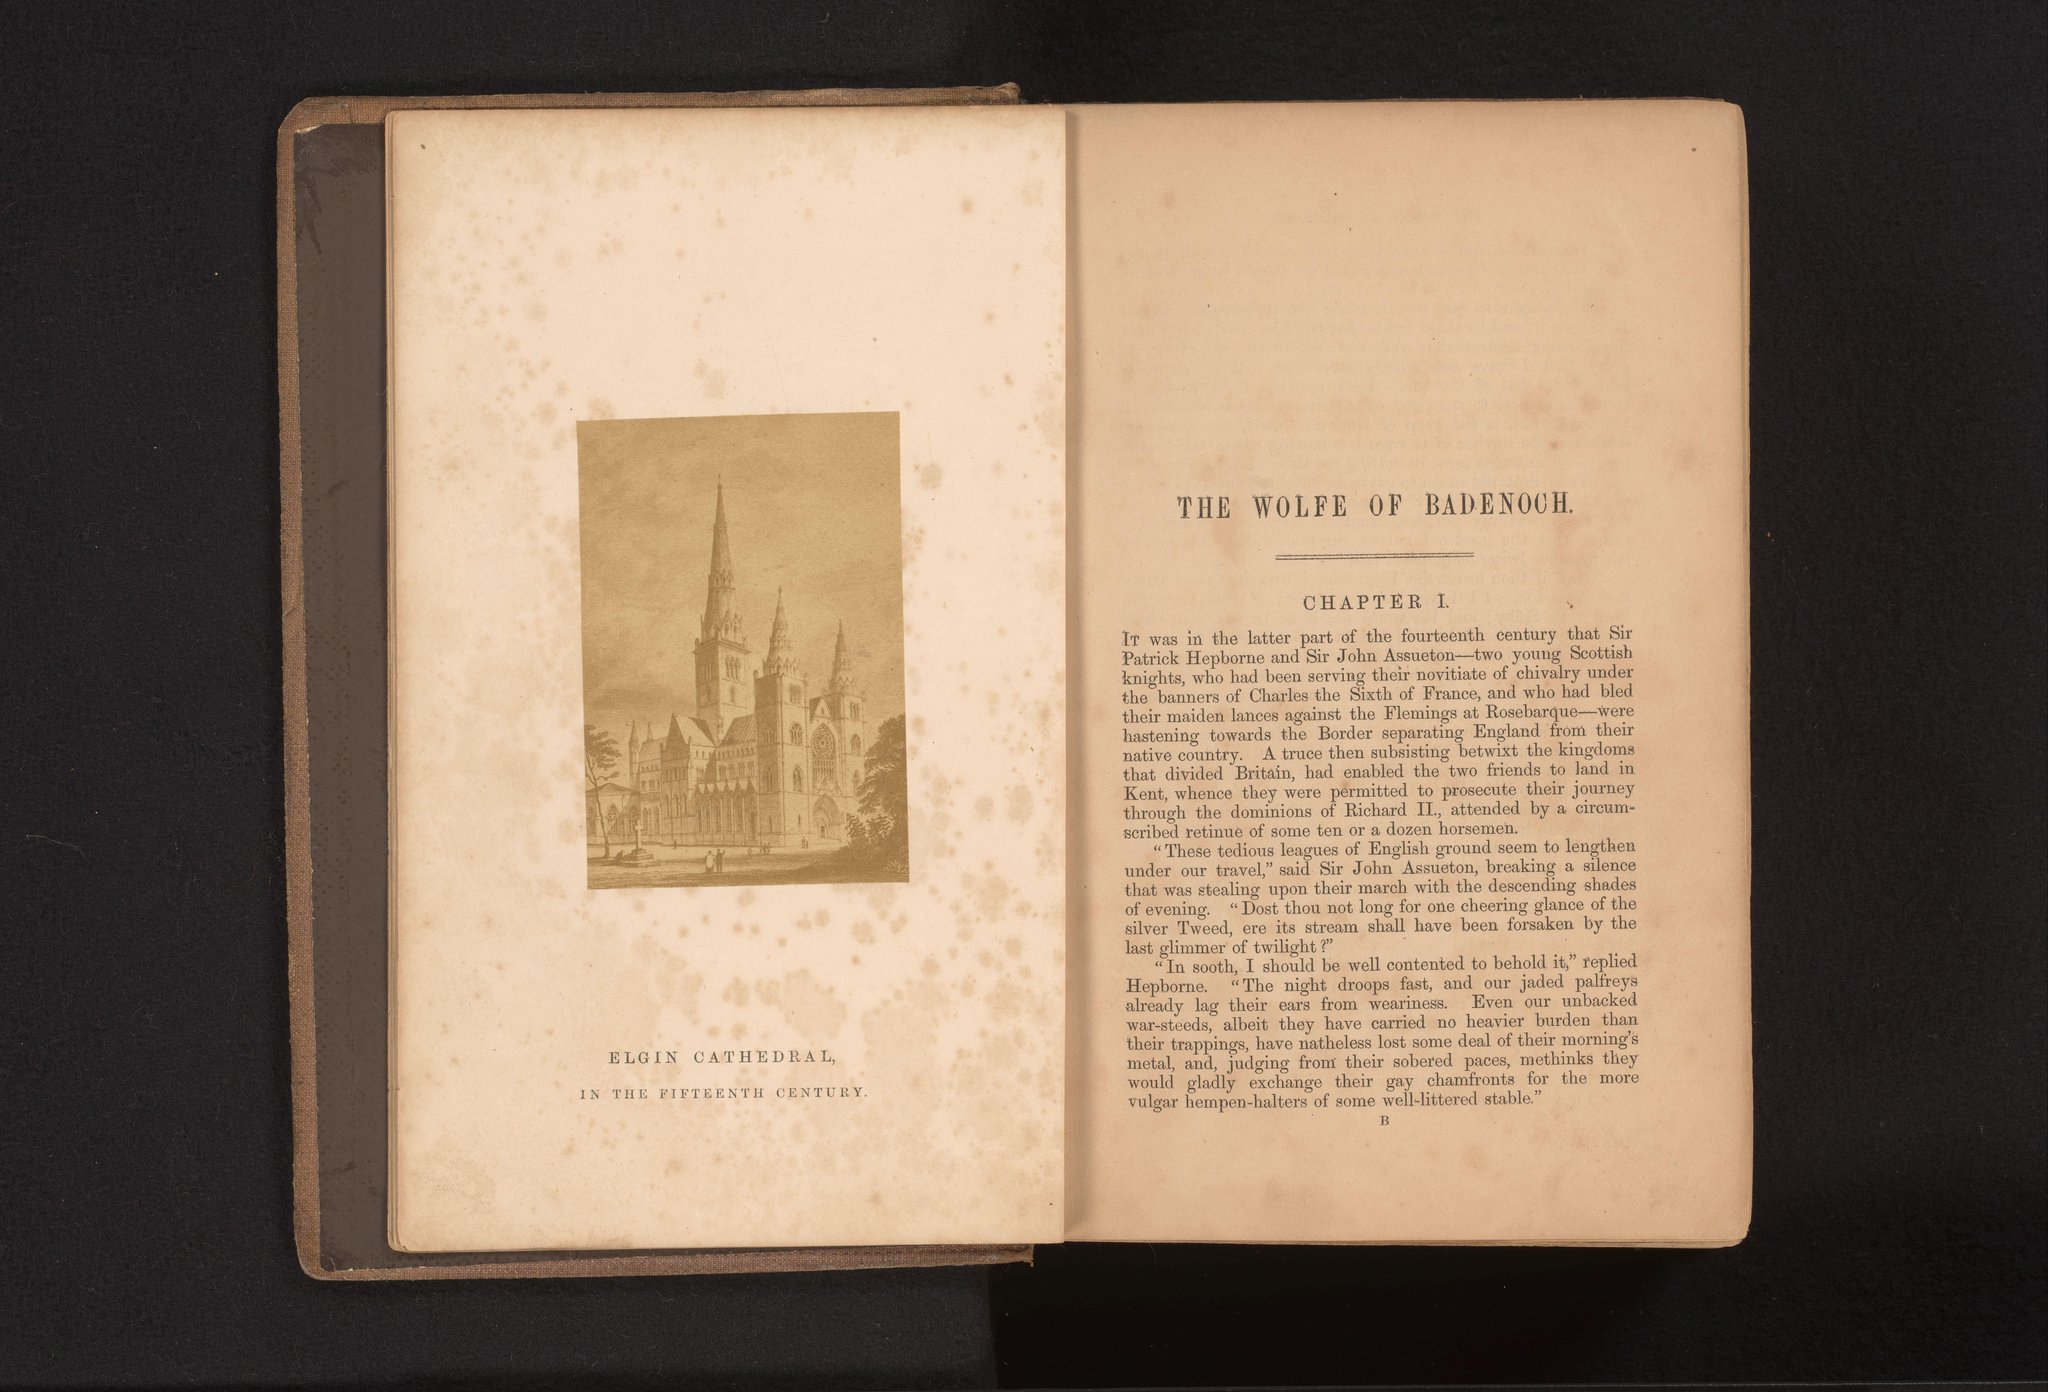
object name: photograph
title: Fotoreproductie van een ontwerp van Elgin Cathedral in de 15e eeuw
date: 1858-1863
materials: photographic support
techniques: albumen print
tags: church (exterior)